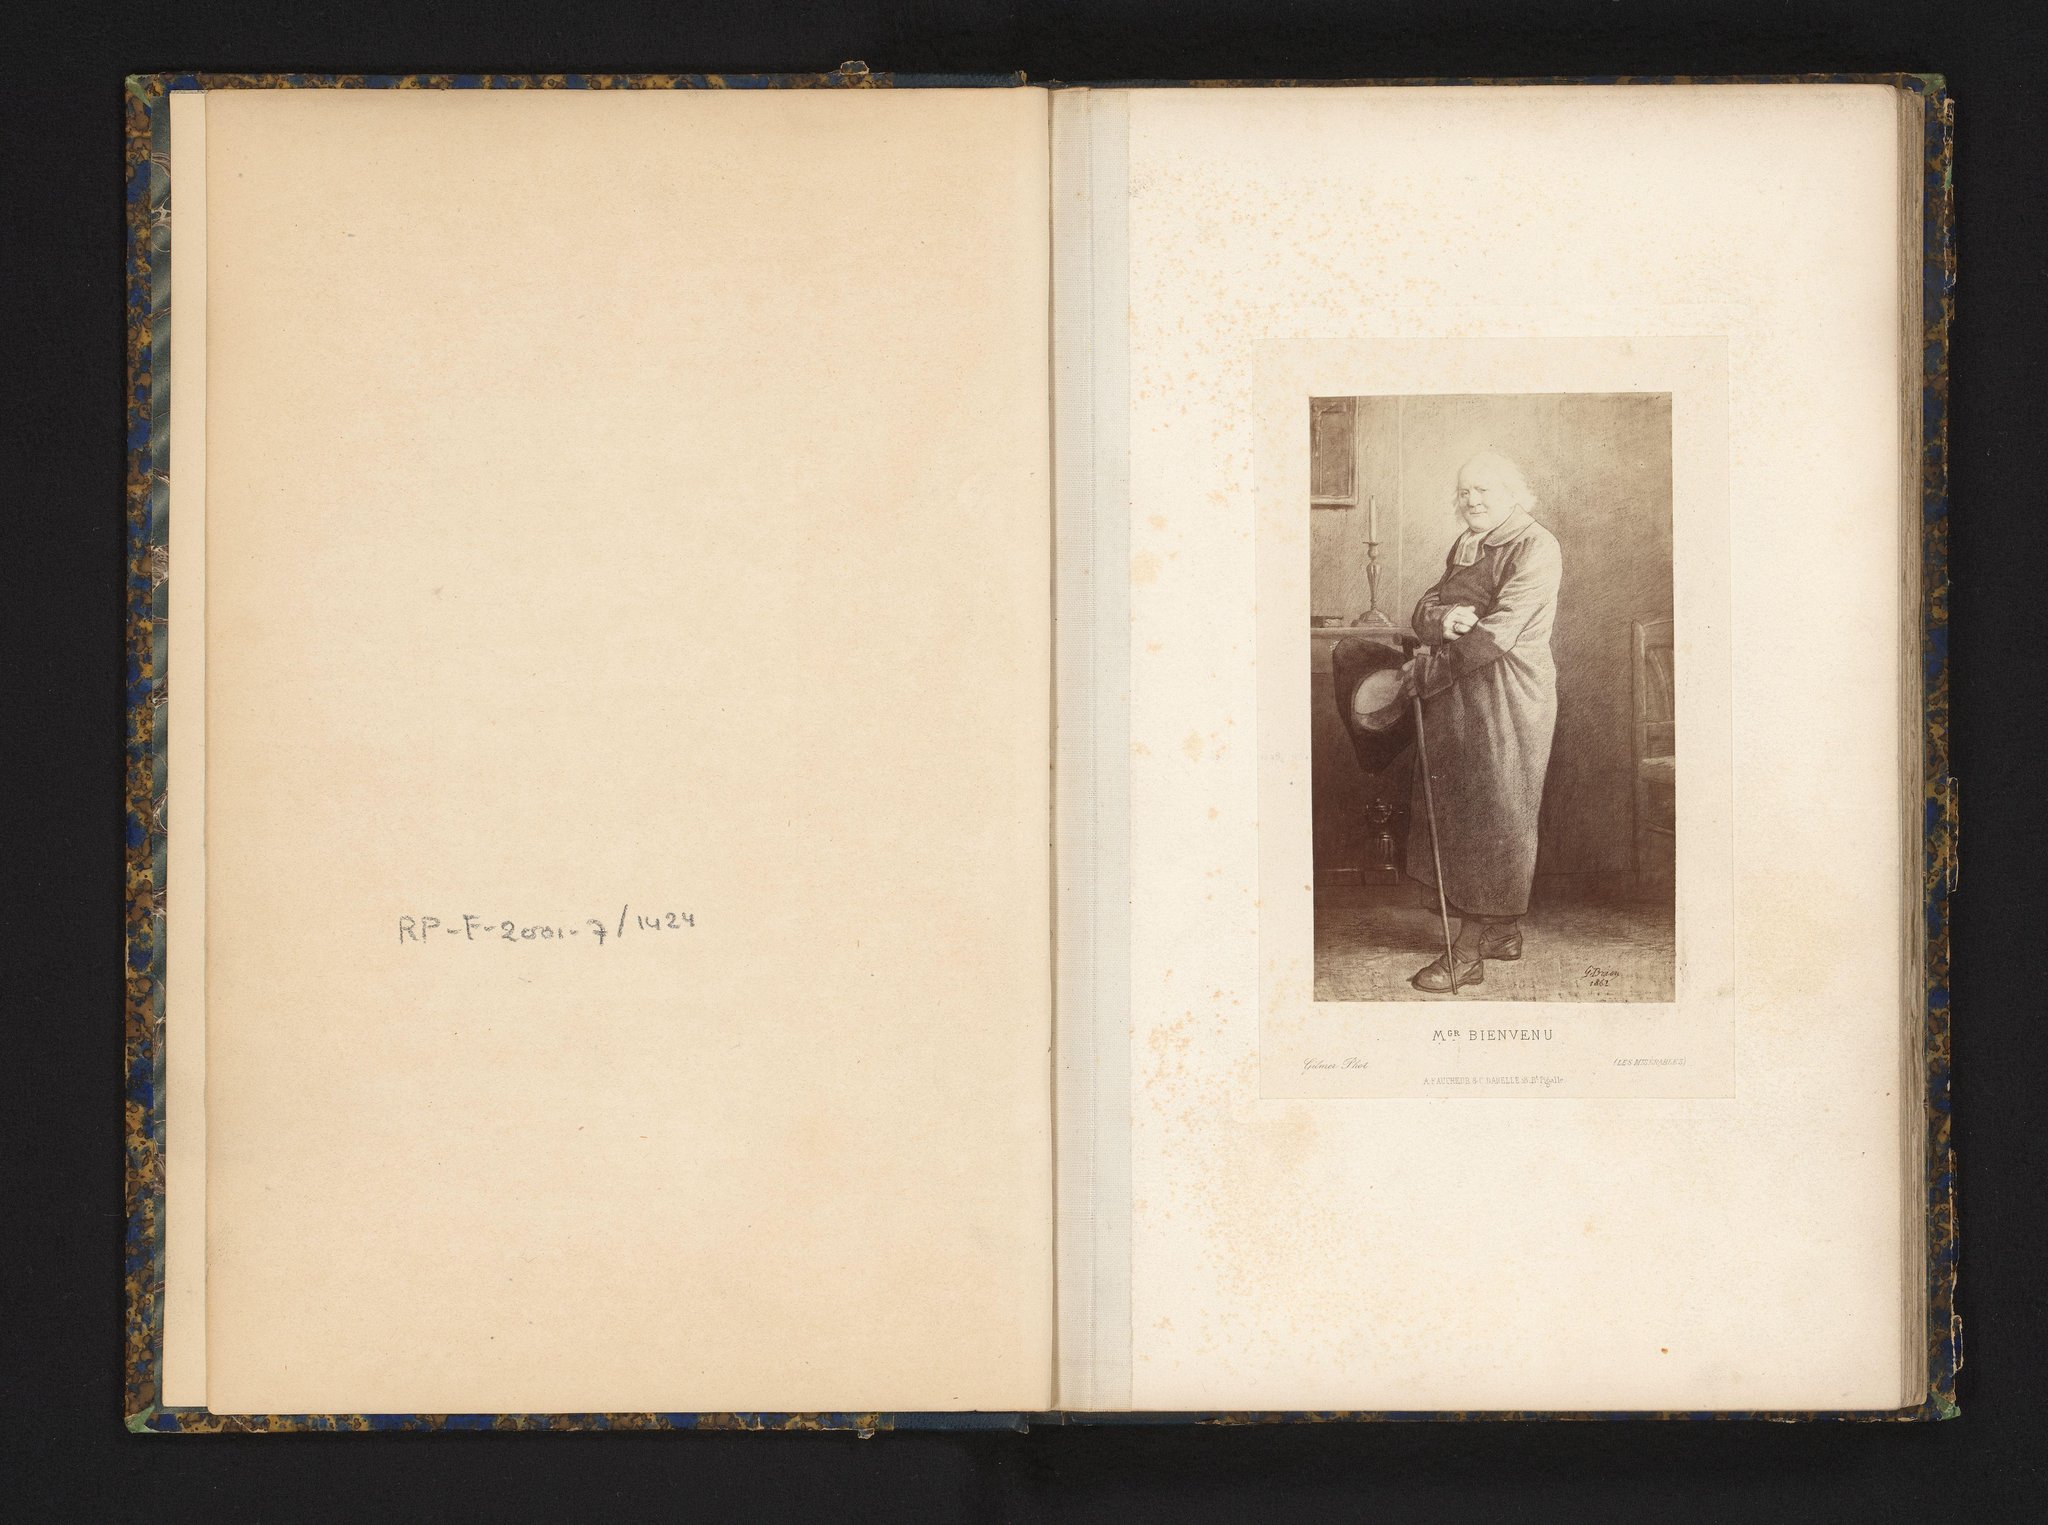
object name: reproduction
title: Fotoreproductie van een tekening van bisschop Bienvenu Myriel uit Les Misérables van Victor Hugo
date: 1862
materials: photographic support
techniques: albumen print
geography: paris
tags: literary characters and objects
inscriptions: address: ‘A. FAUCHEUR & C. DANELLE 18, Bt. Pigalle.’, inscription: ‘(LES MISÉRABLES)’